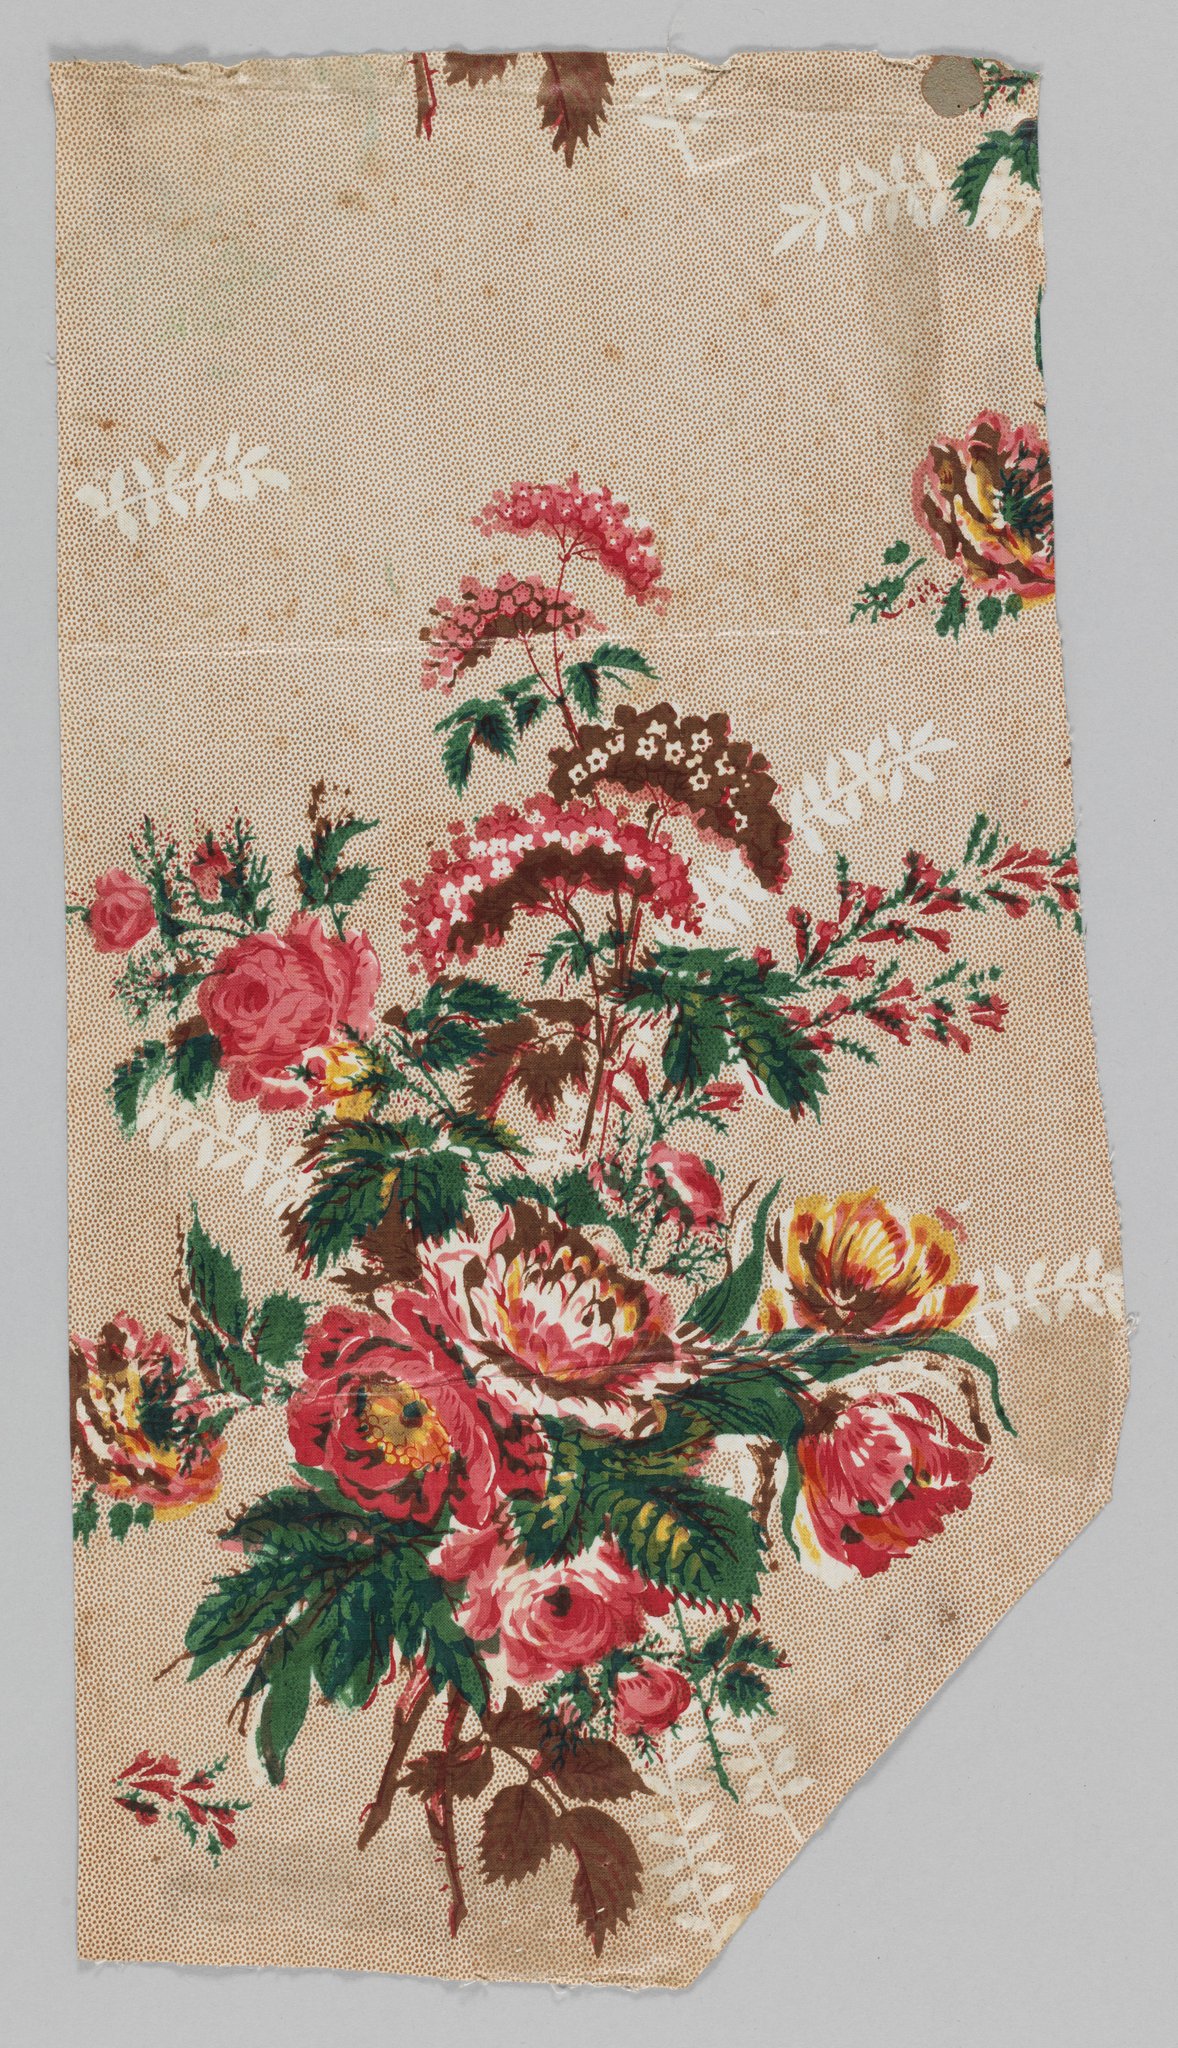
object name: piece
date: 1801-1900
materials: cotton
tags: roses